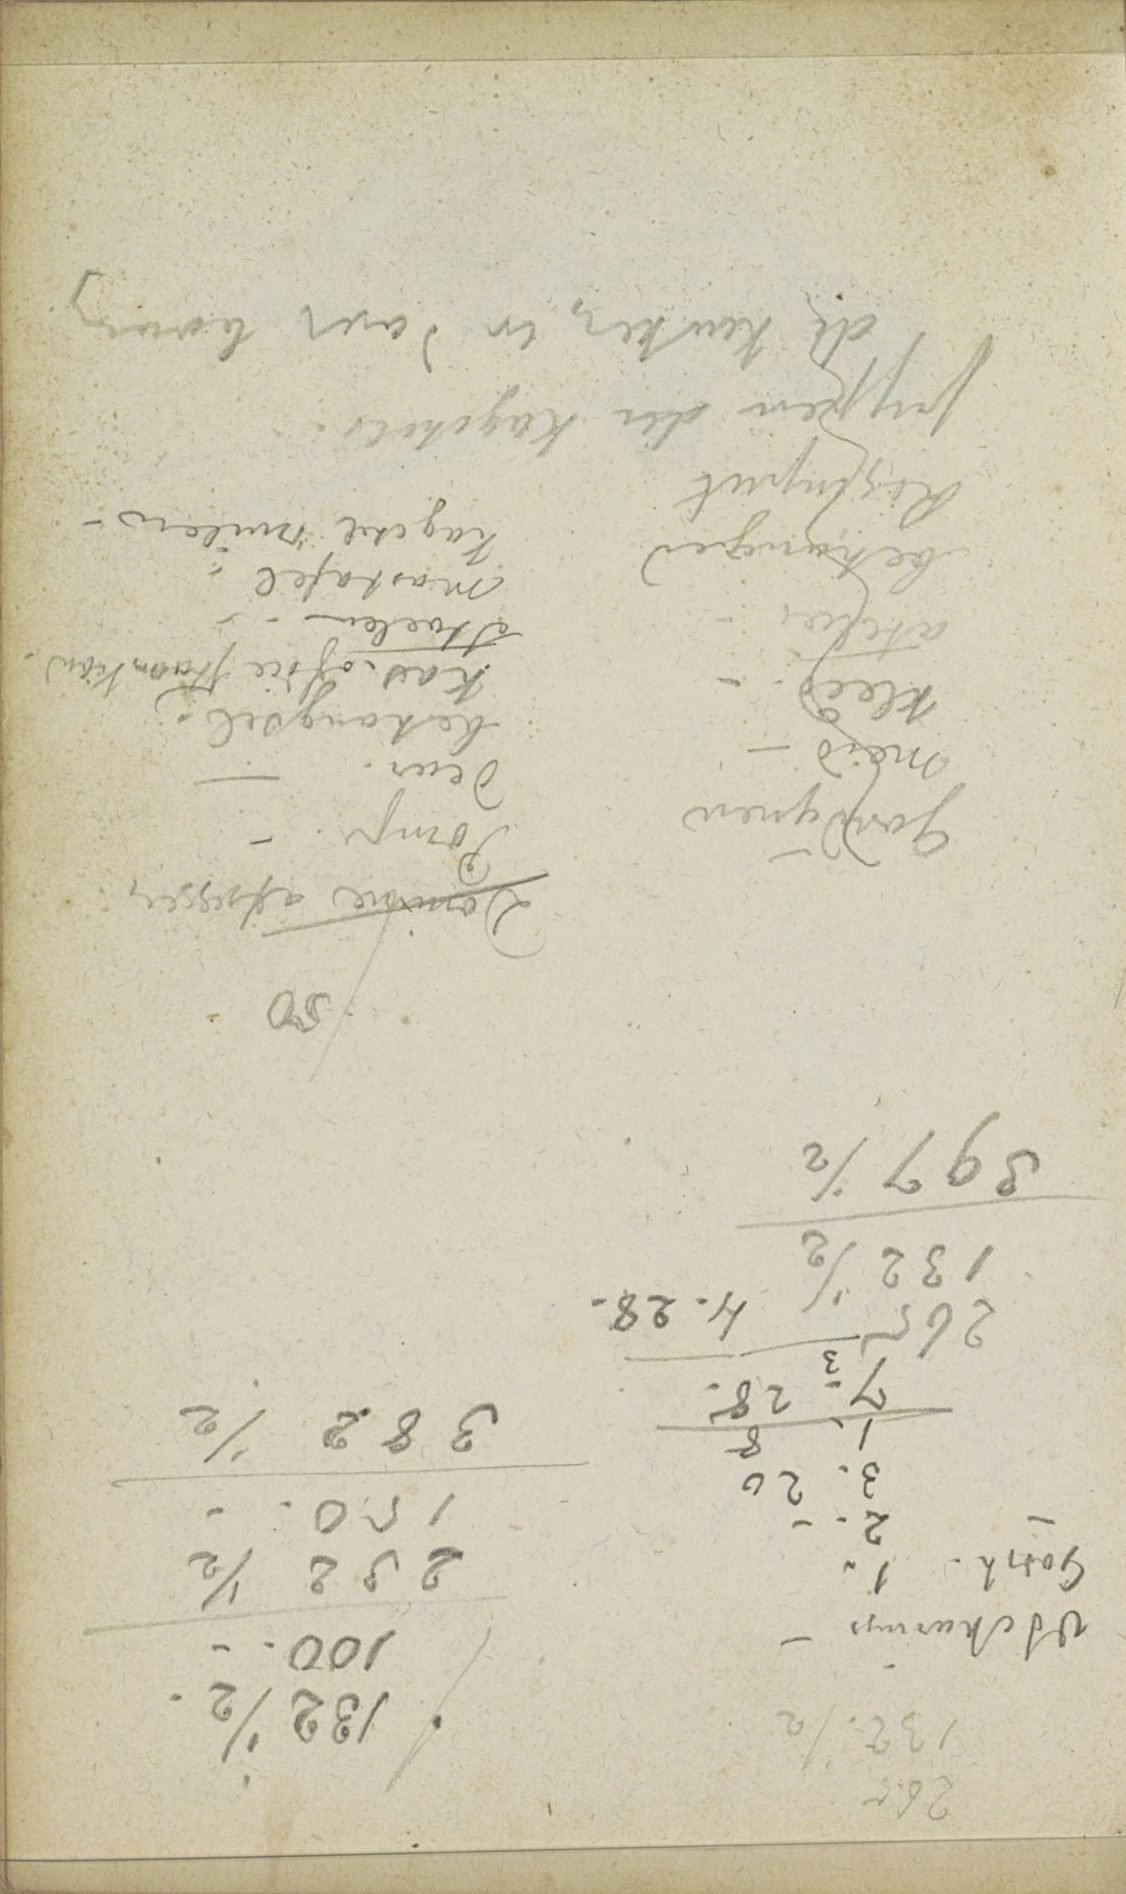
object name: sketchbook leaf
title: Berekeningen en huishoudelijke lijsten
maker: johannes tavenraat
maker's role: draughtsman, painter, print maker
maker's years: 1809-1881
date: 1854-1868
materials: paper, pencil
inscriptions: annotation: ‘[...]’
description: Blad 85 verso uit een schetsboek met 88 bladen.